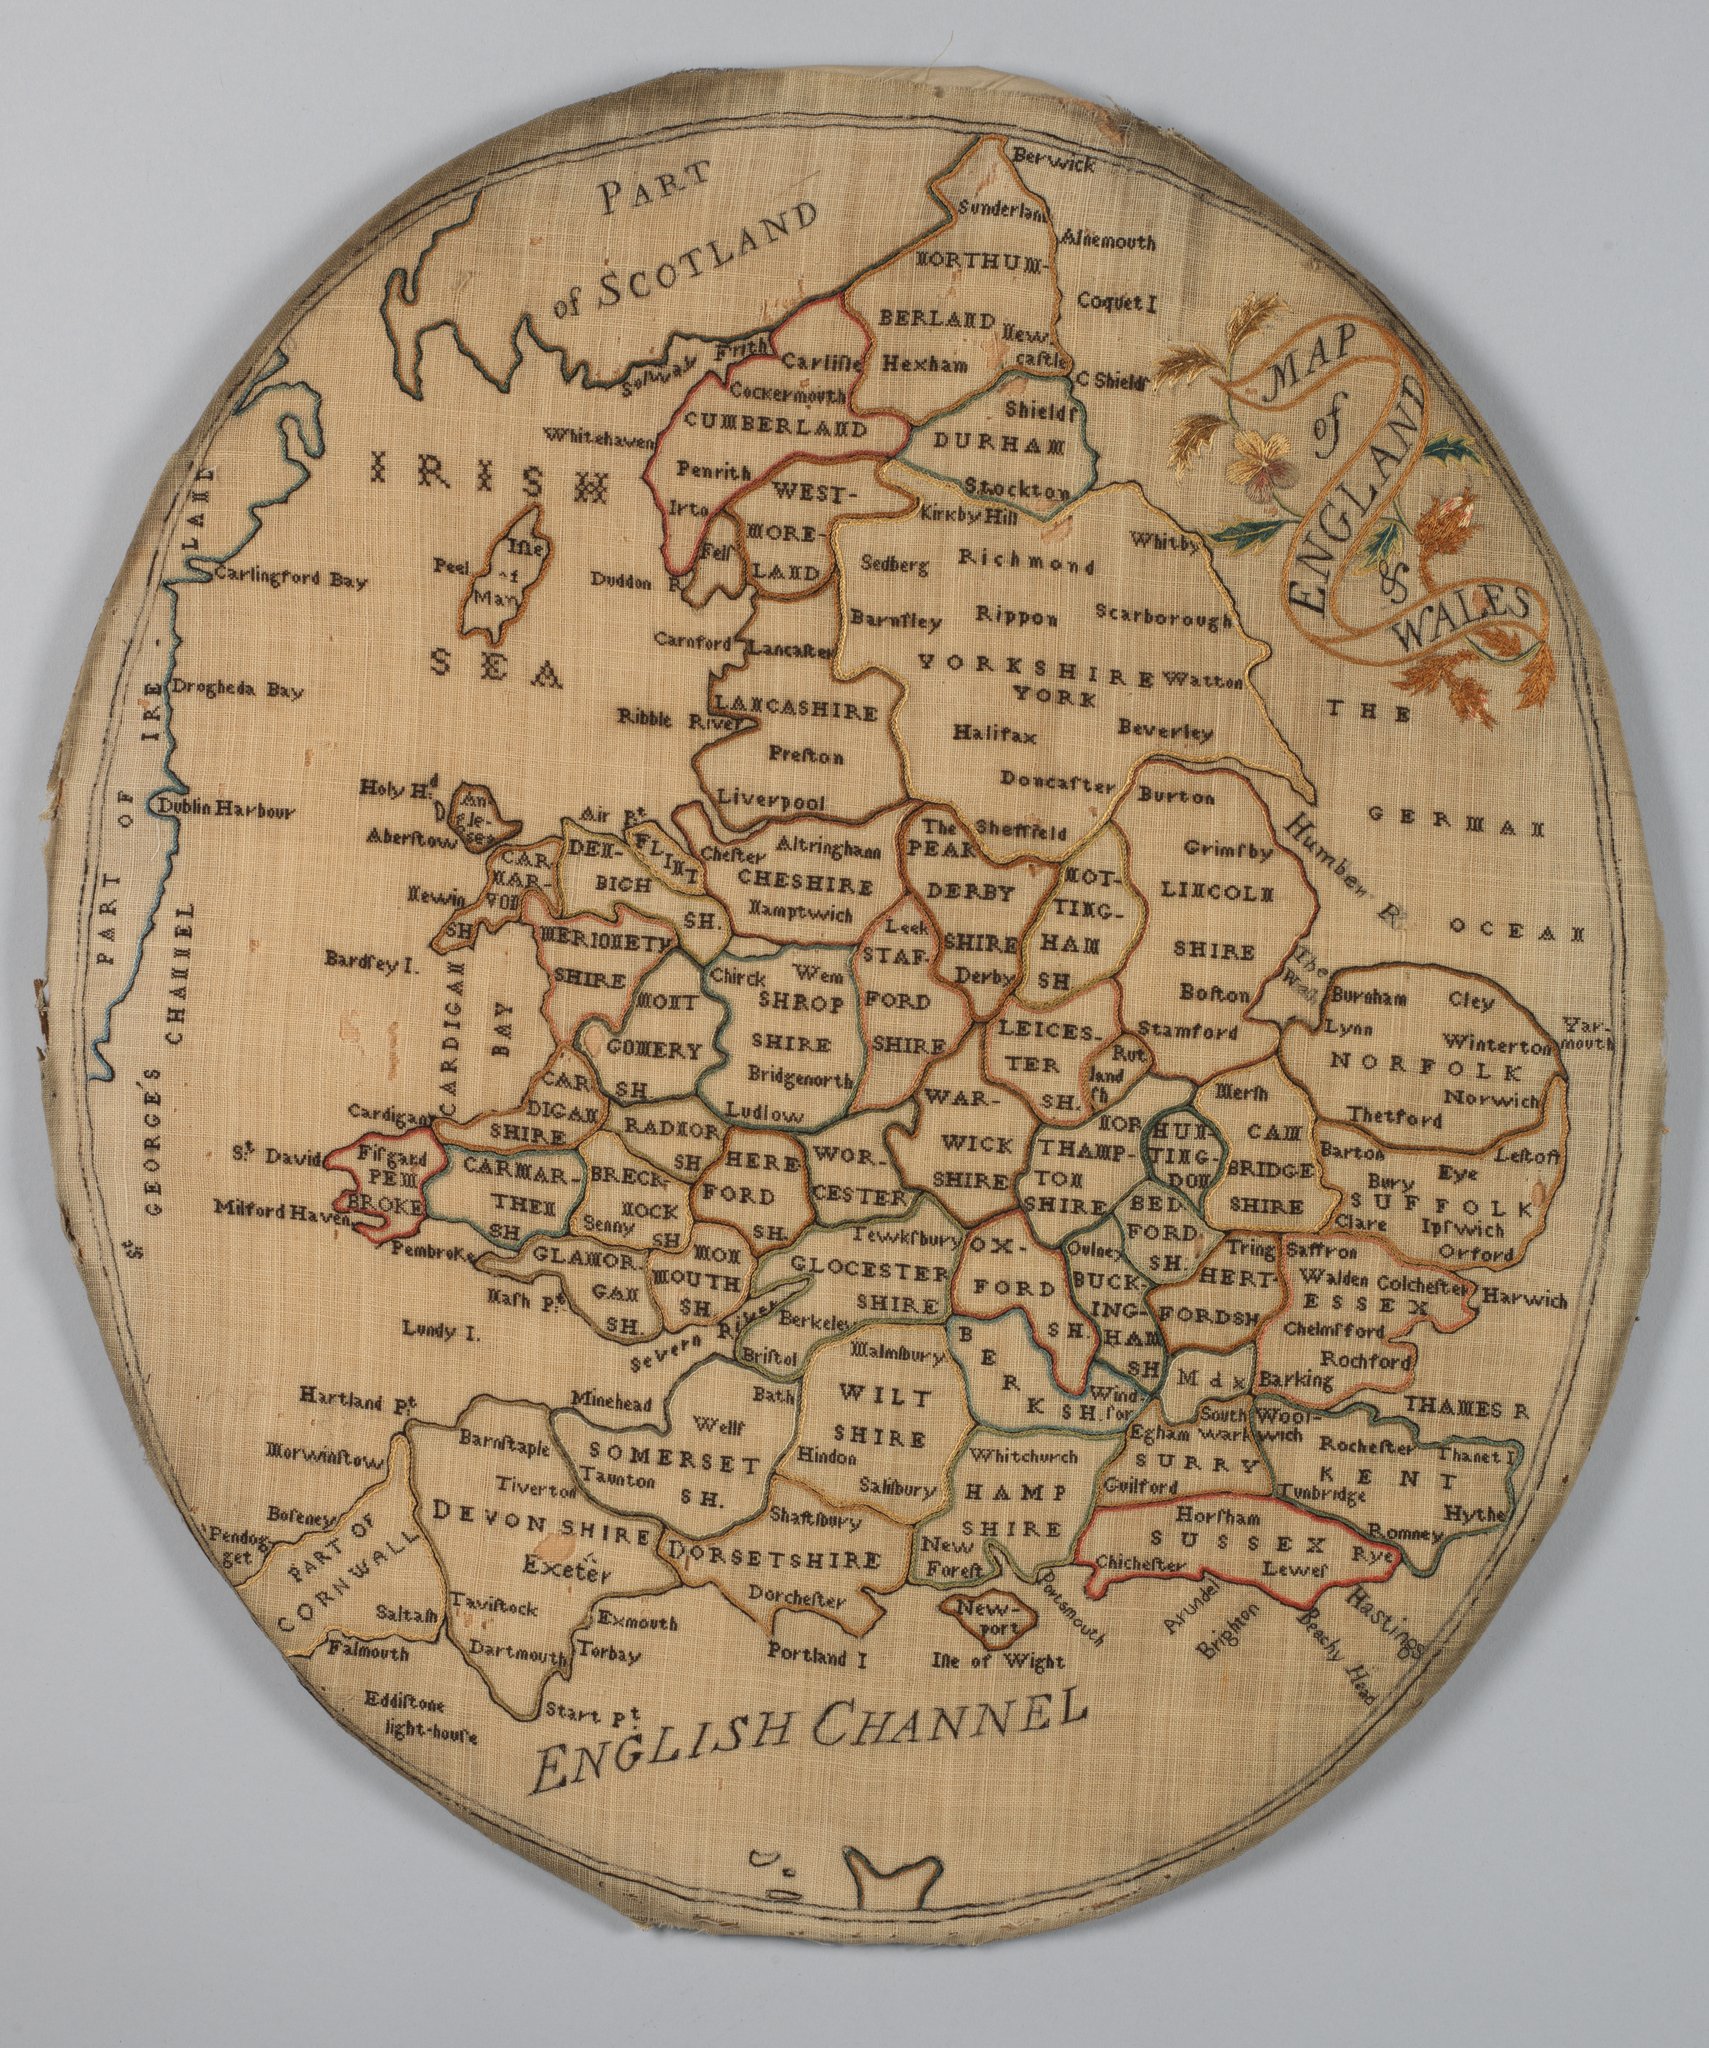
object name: sampler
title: Embroidered map sampler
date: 1822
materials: silk, wool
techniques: embroidery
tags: maps